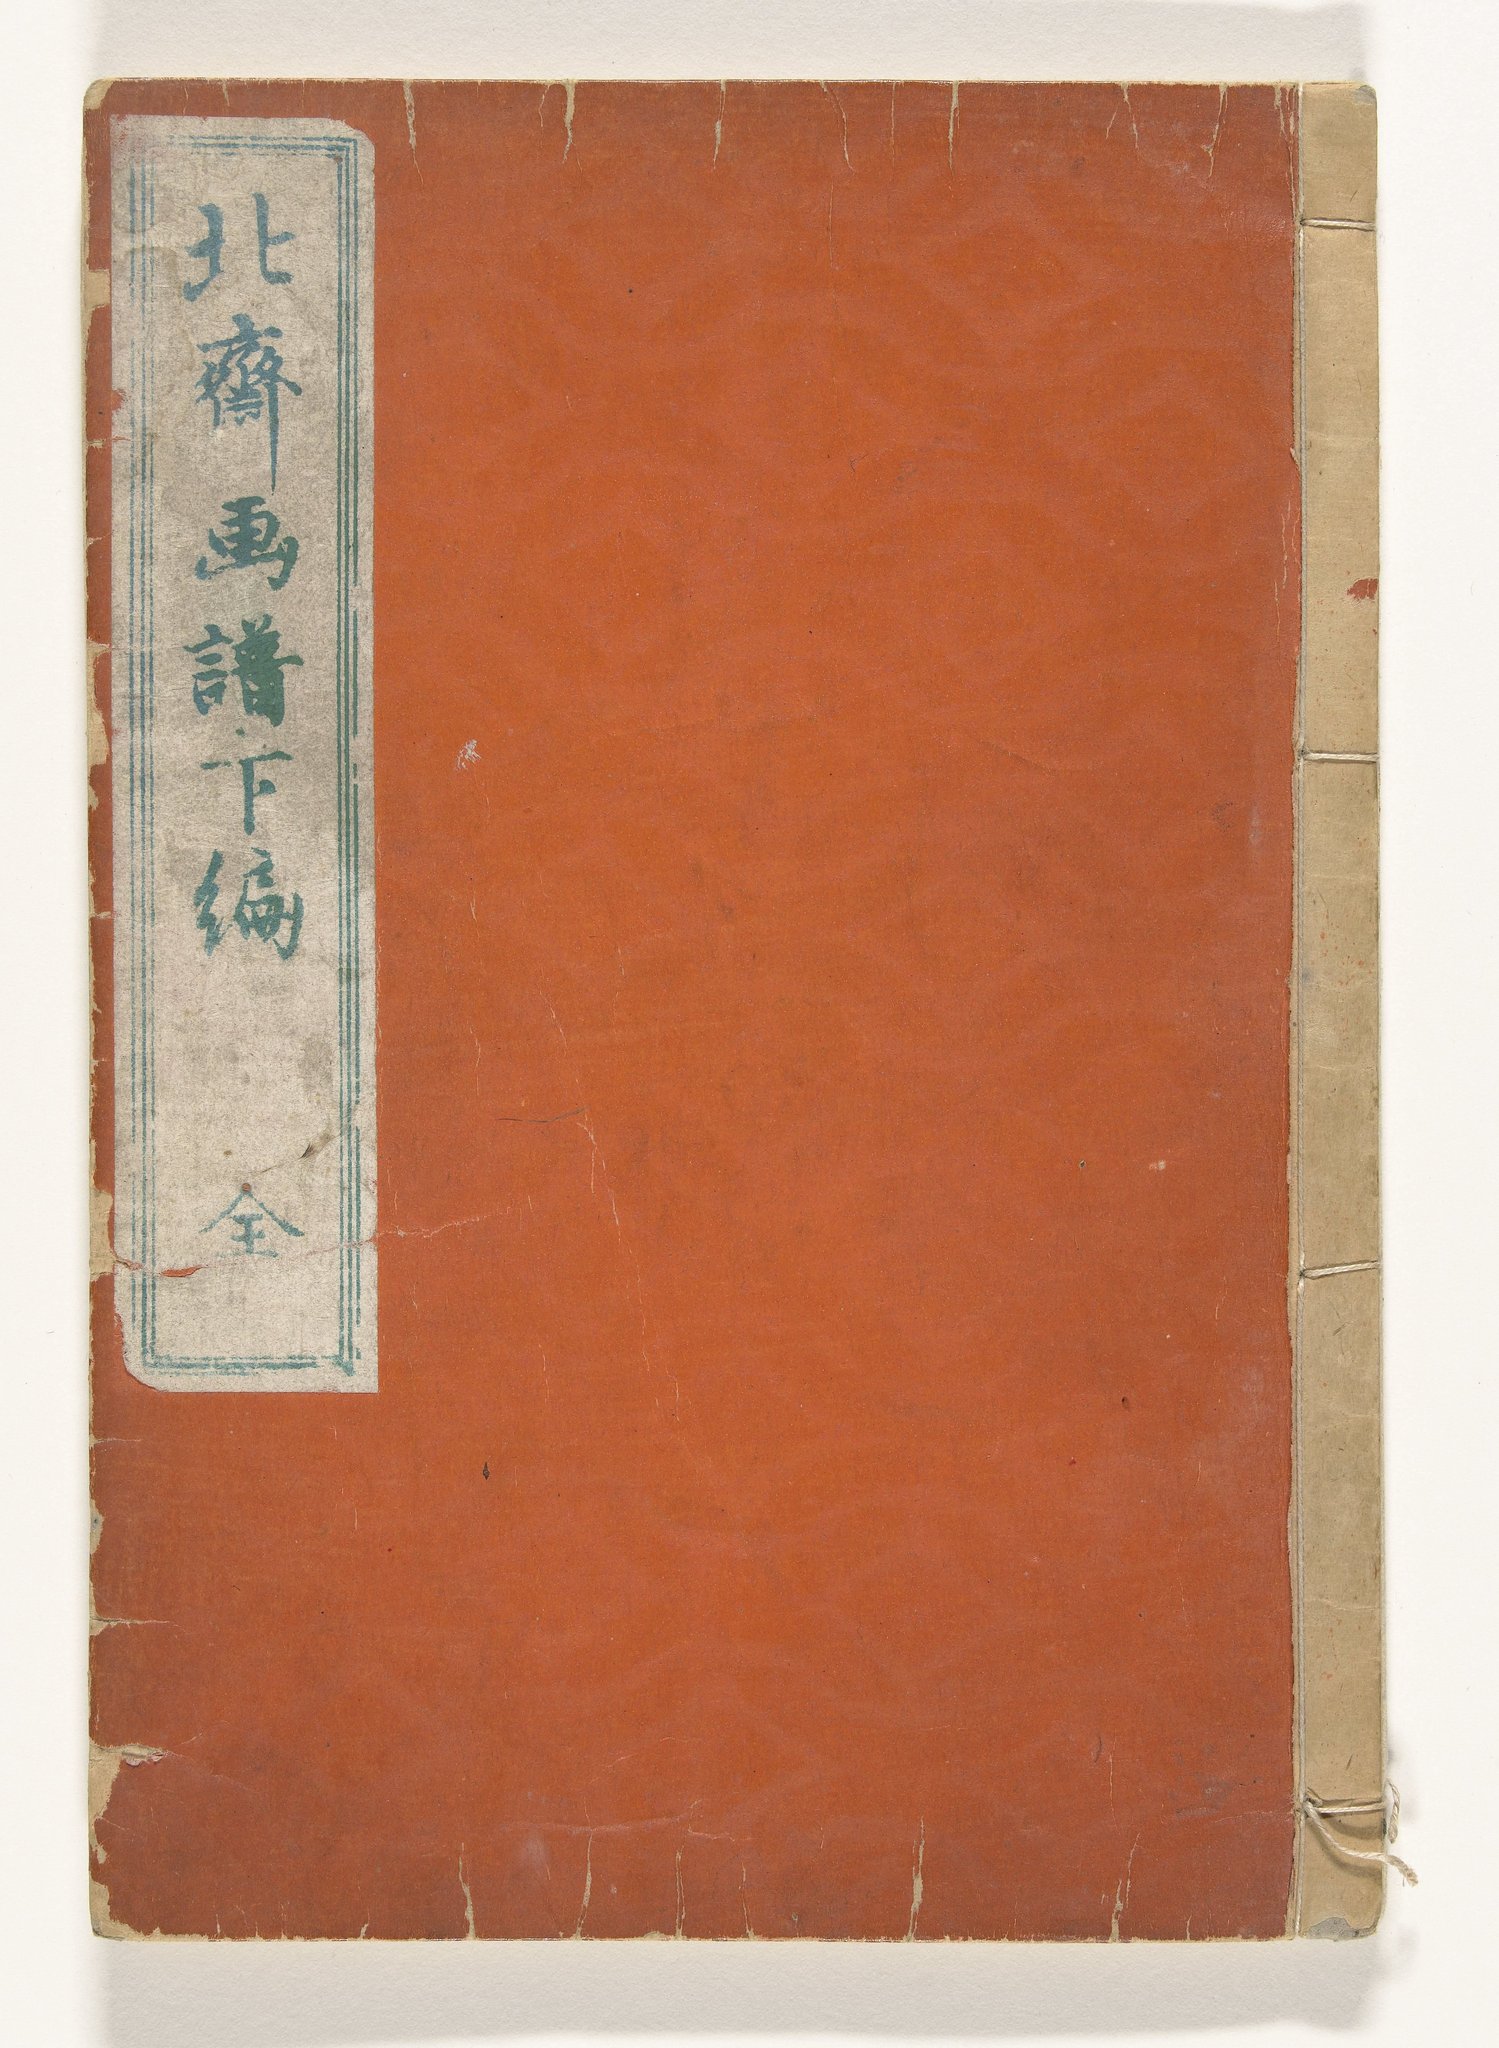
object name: book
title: Schetsboek van Hokusai - derde deel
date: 1849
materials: paper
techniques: woodcut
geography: japan